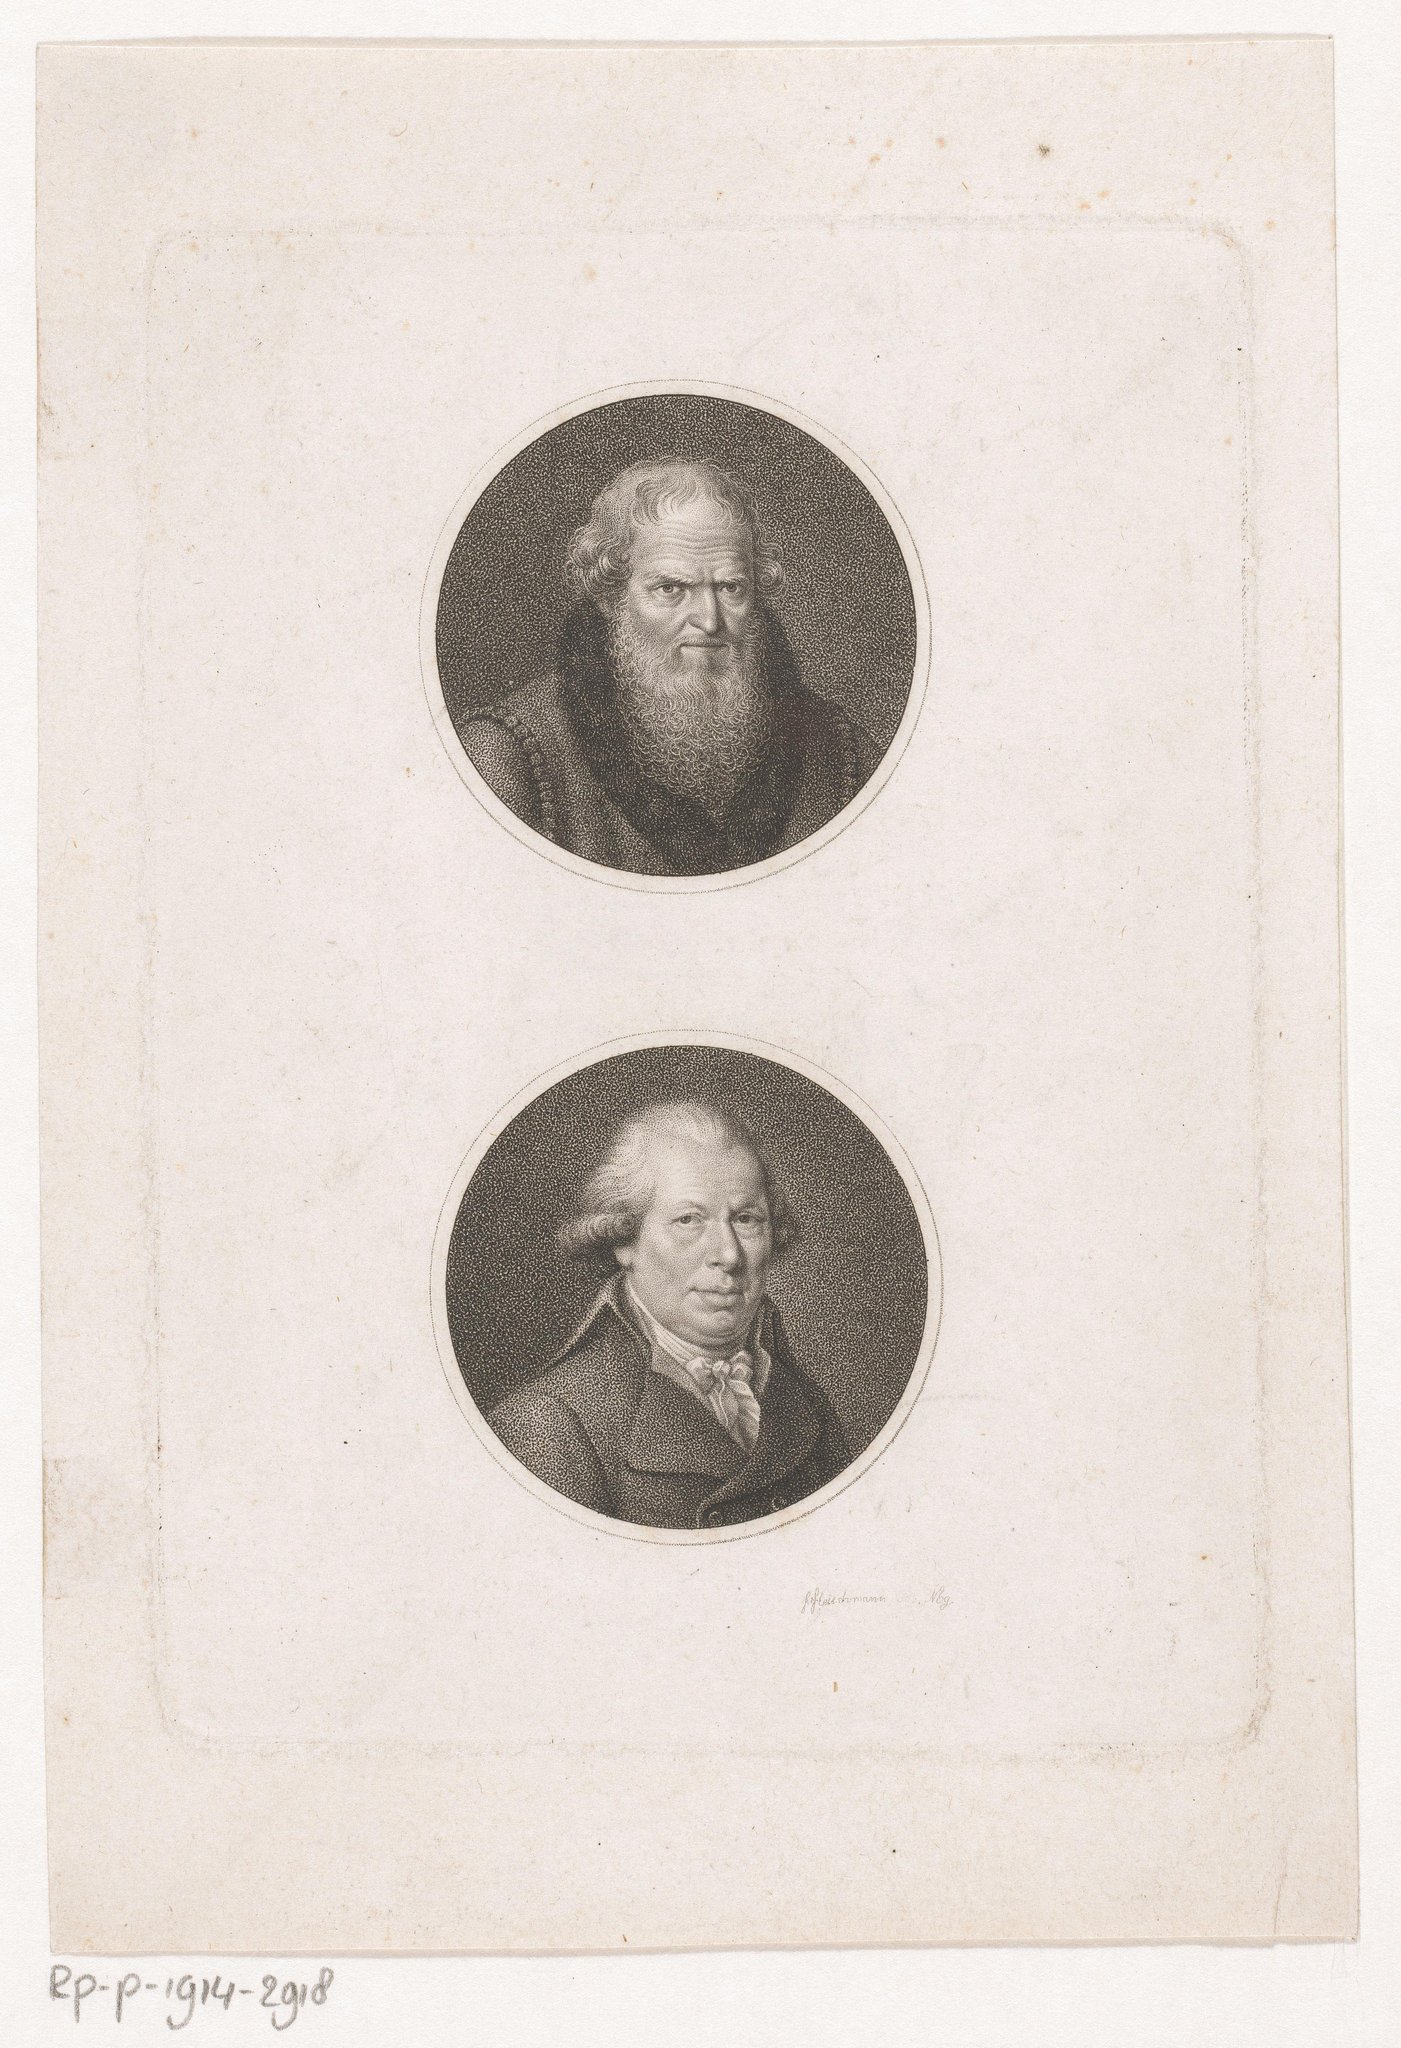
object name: print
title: Twee medaillons met de portretten van Hans Sachs en een onbekende man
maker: friedrich fleischmann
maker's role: print maker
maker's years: 1791-1834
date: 1801-1834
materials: paper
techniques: stippling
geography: nuremberg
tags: hans sachs, historical persons, writer, poet, author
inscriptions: collector's mark: Lugt 2228